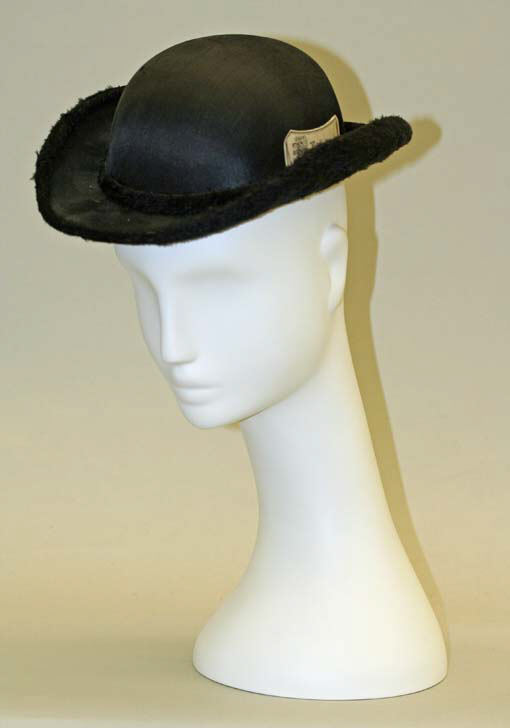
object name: riding hat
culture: british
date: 1857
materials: cotton, silk